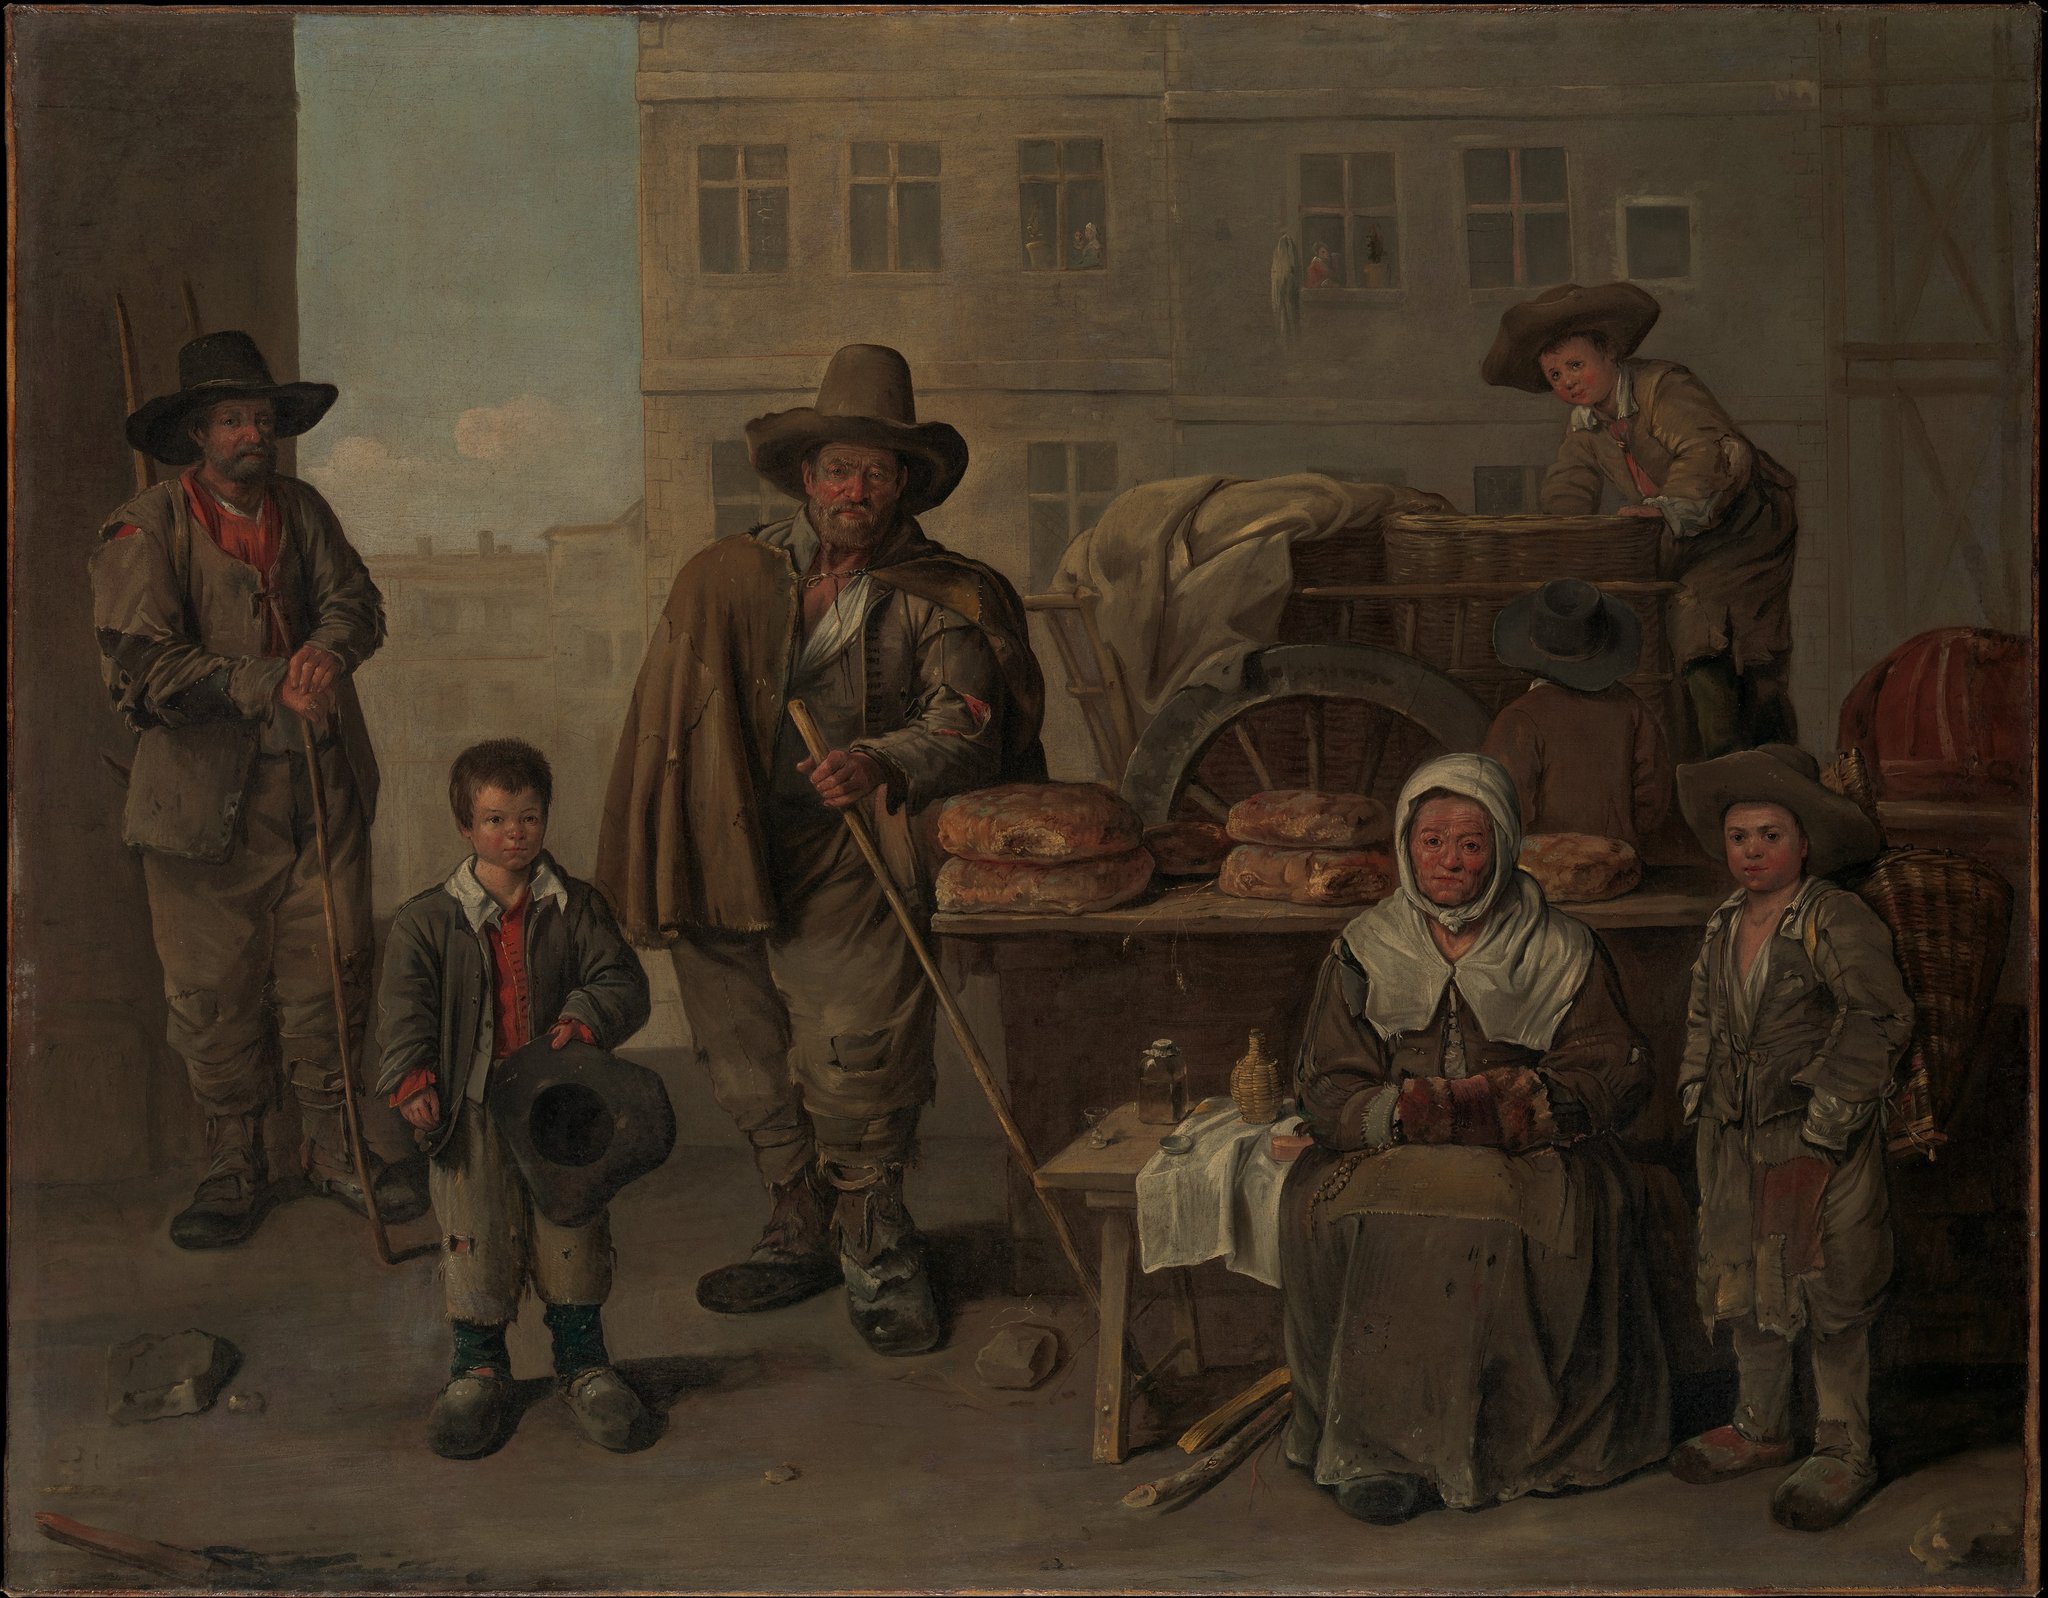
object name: painting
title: The Baker's Cart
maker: jean michelin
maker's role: artist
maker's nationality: french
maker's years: 1616-1670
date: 1656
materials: canvas, oil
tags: bread,boys,men,women,bakers,carts